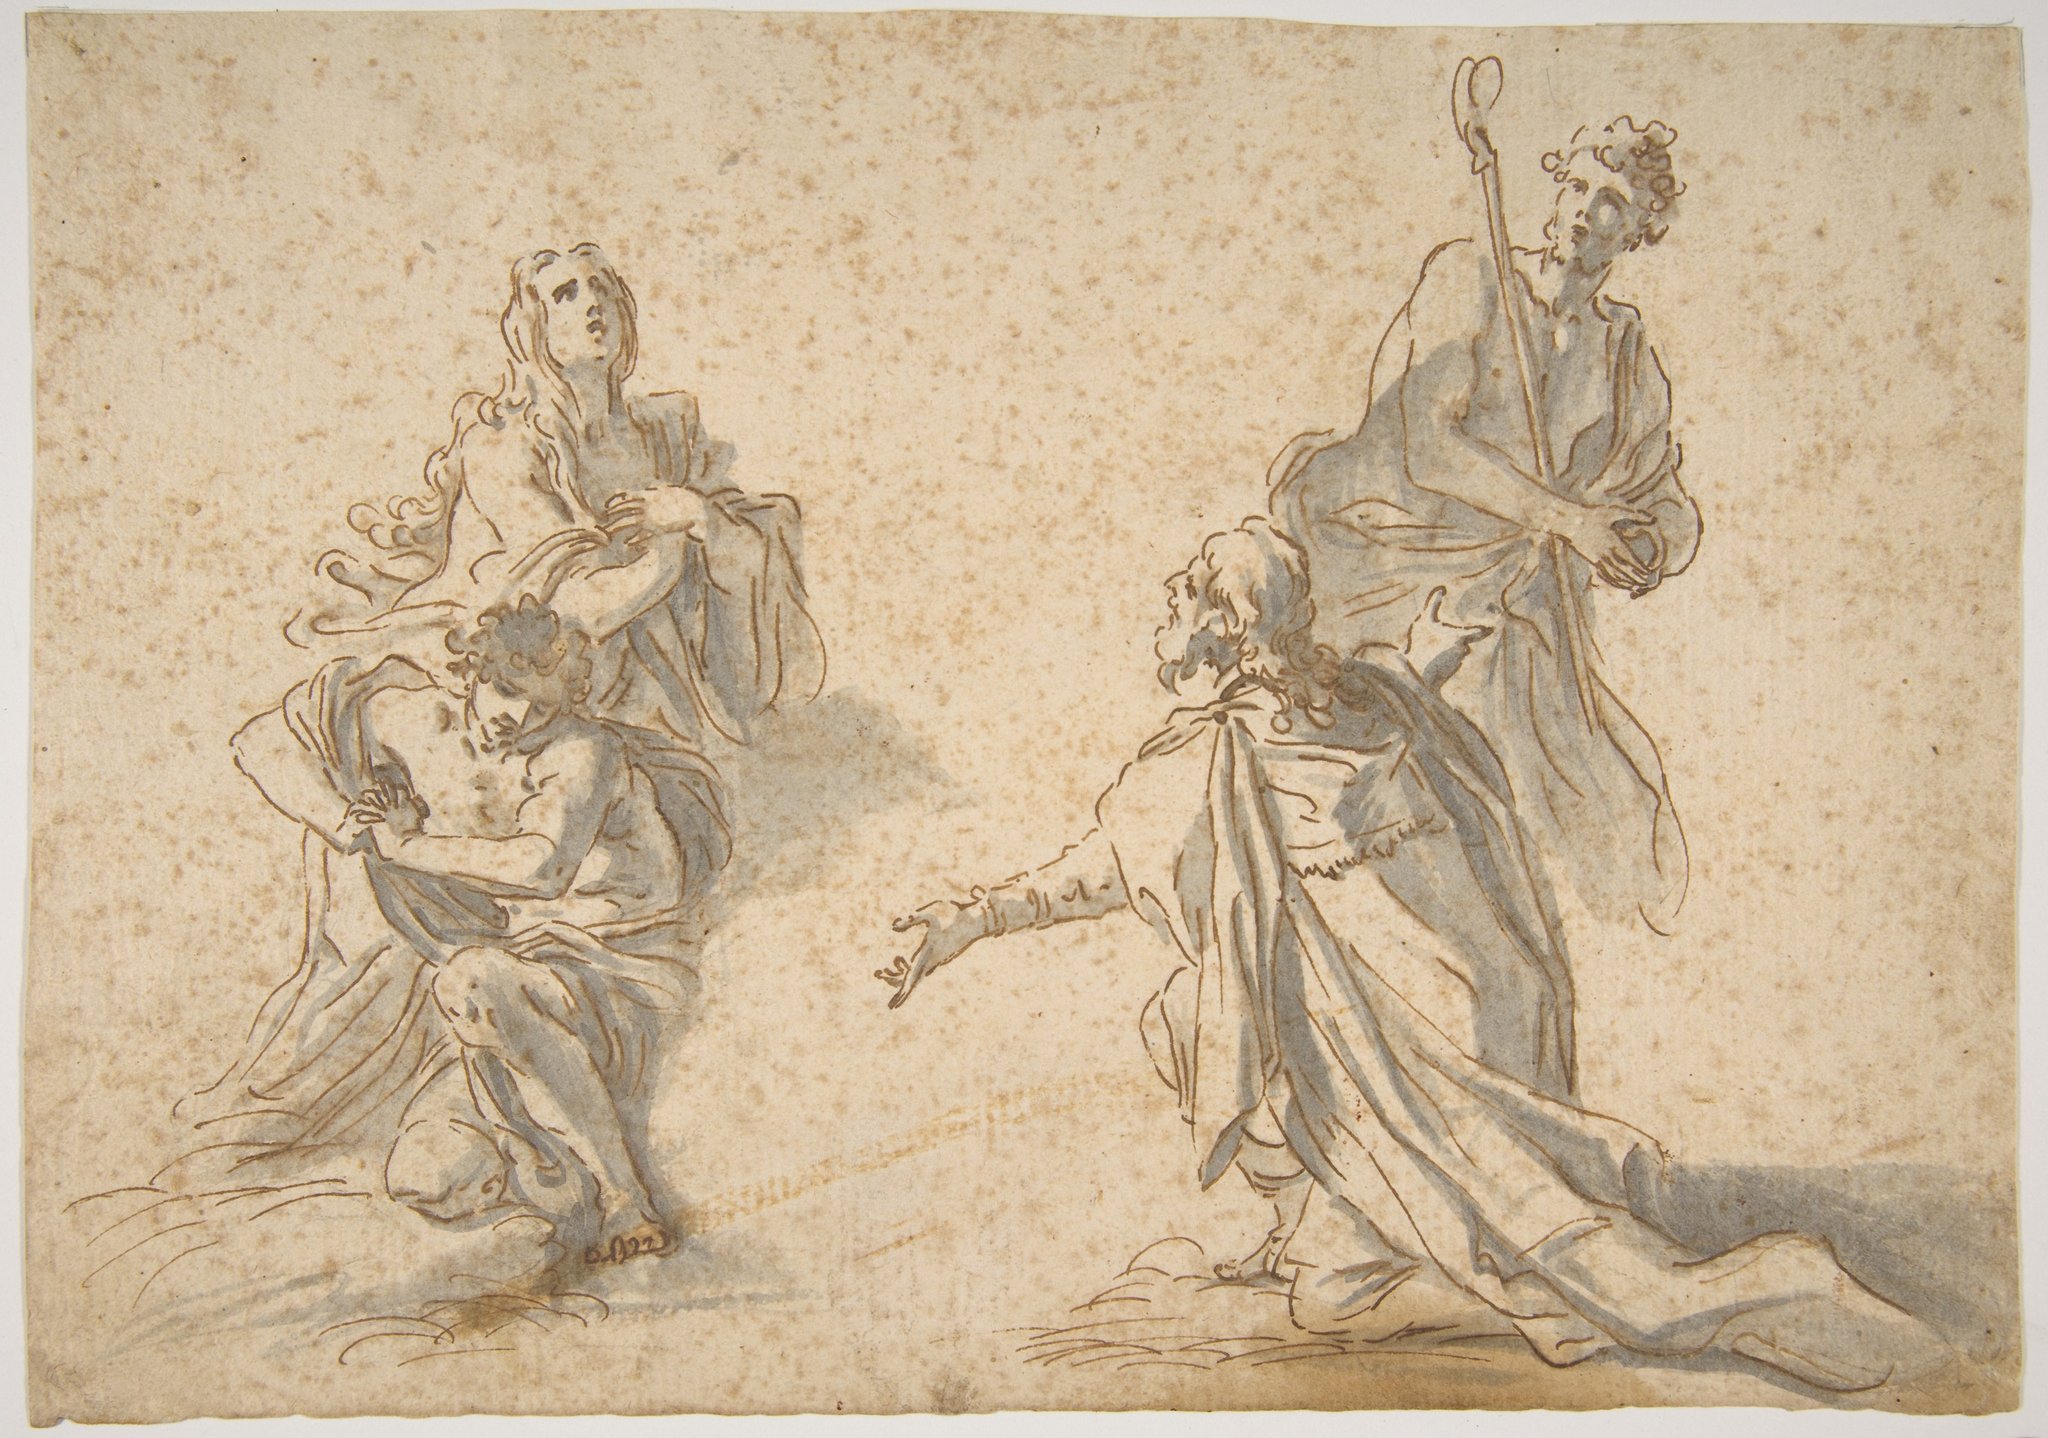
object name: drawing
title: Two Kneeling and Two Standing Figures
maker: nicola maria rossi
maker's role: artist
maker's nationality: italian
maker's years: 1690-1758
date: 1690-1758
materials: chalk, ink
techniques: pen, wash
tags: men,women